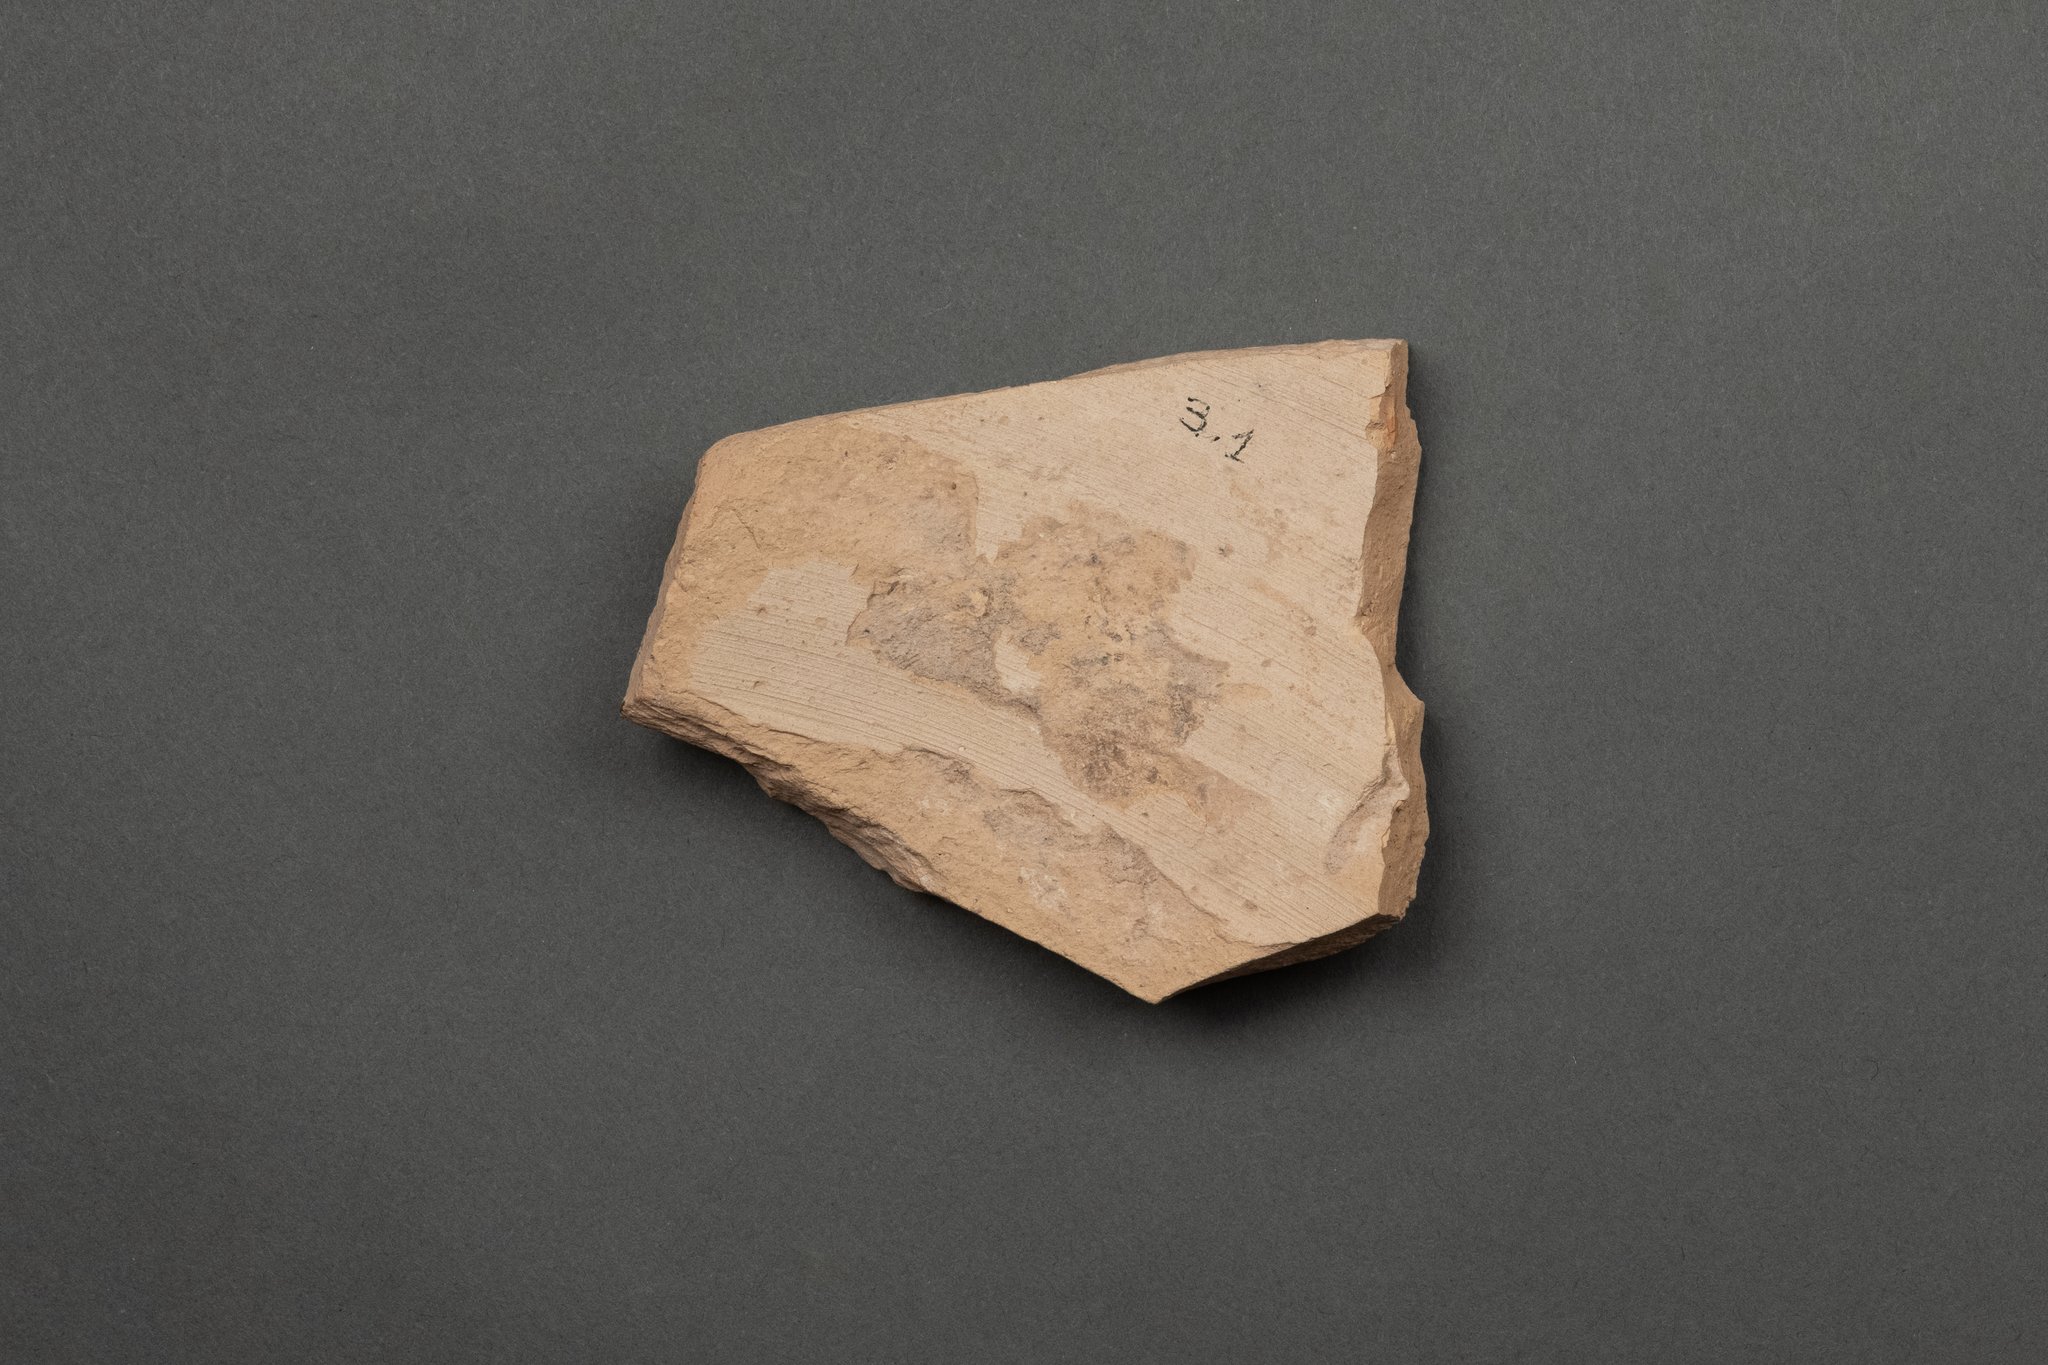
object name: fragment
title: Ceramic Fragment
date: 801-1000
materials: earthenware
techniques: painting, polychrome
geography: iran